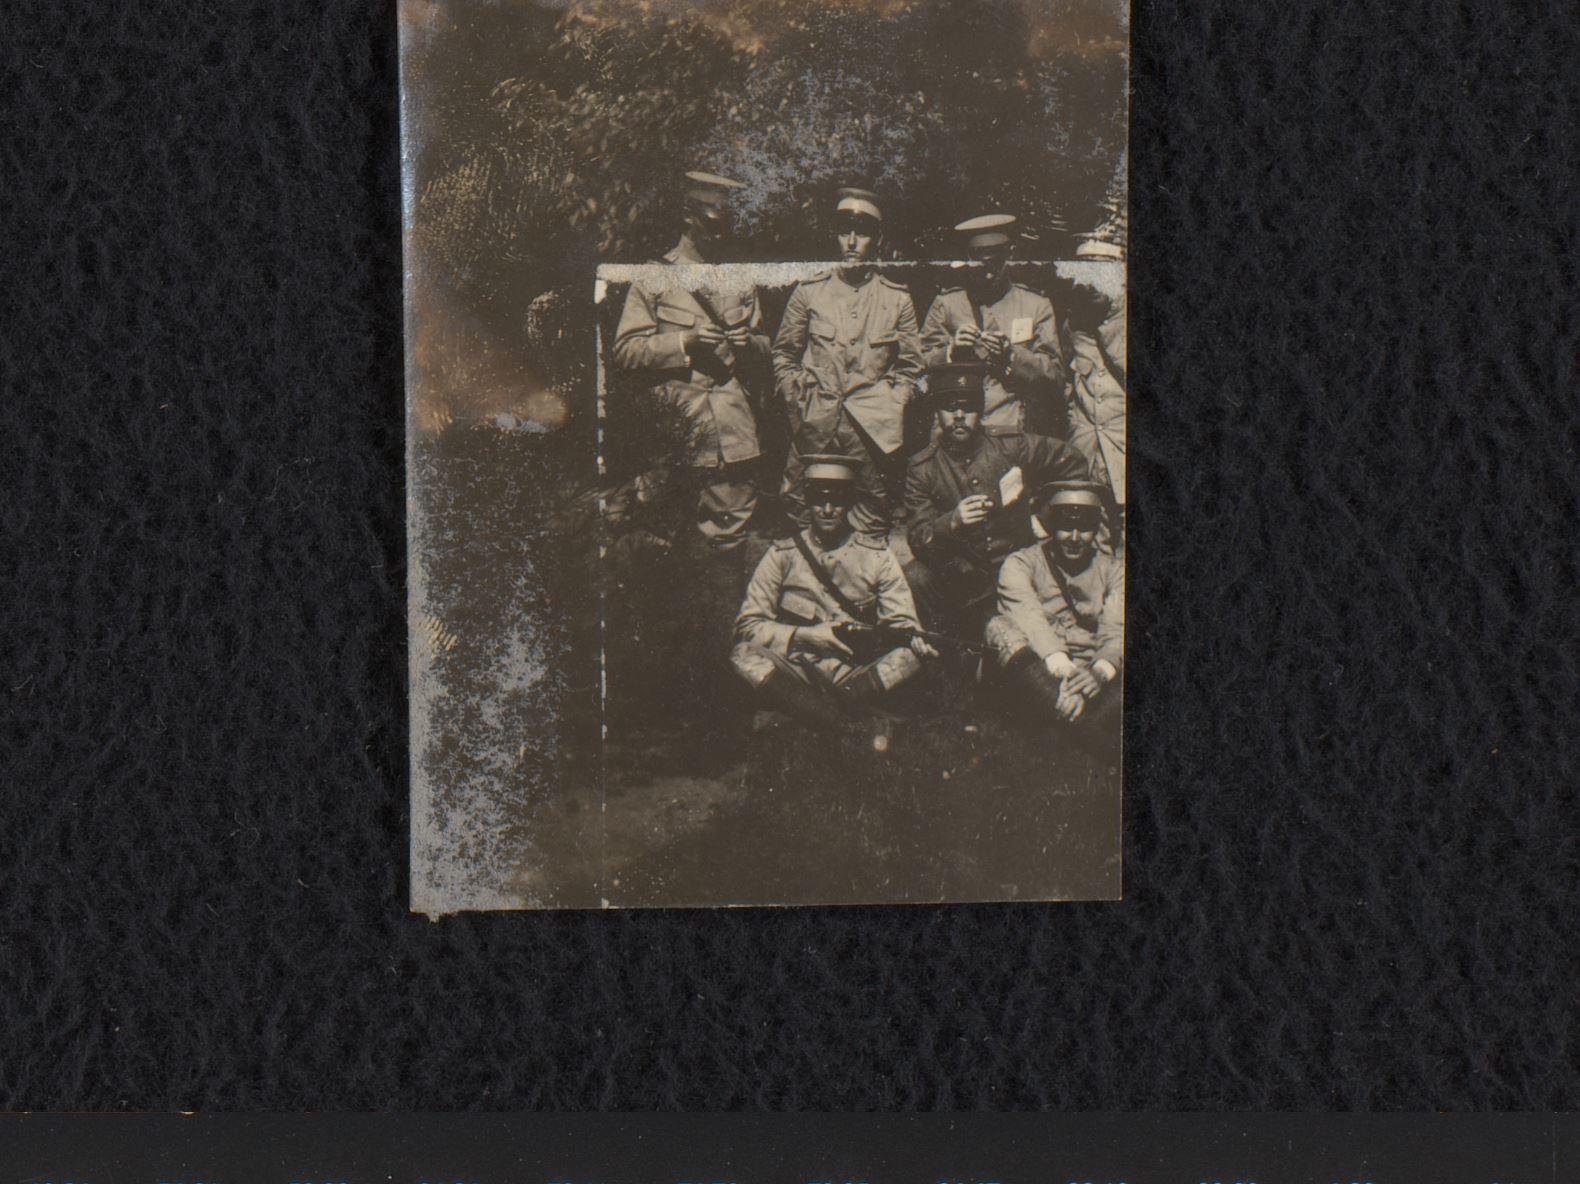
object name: photograph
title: Groepsportret van soldaten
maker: Anonymous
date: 1900-1930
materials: paper, cardboard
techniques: gelatin silver print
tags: anonymous historical persons portrayed in a group, in a group-portrait - bb - woman, recreation ~ the soldier off duty